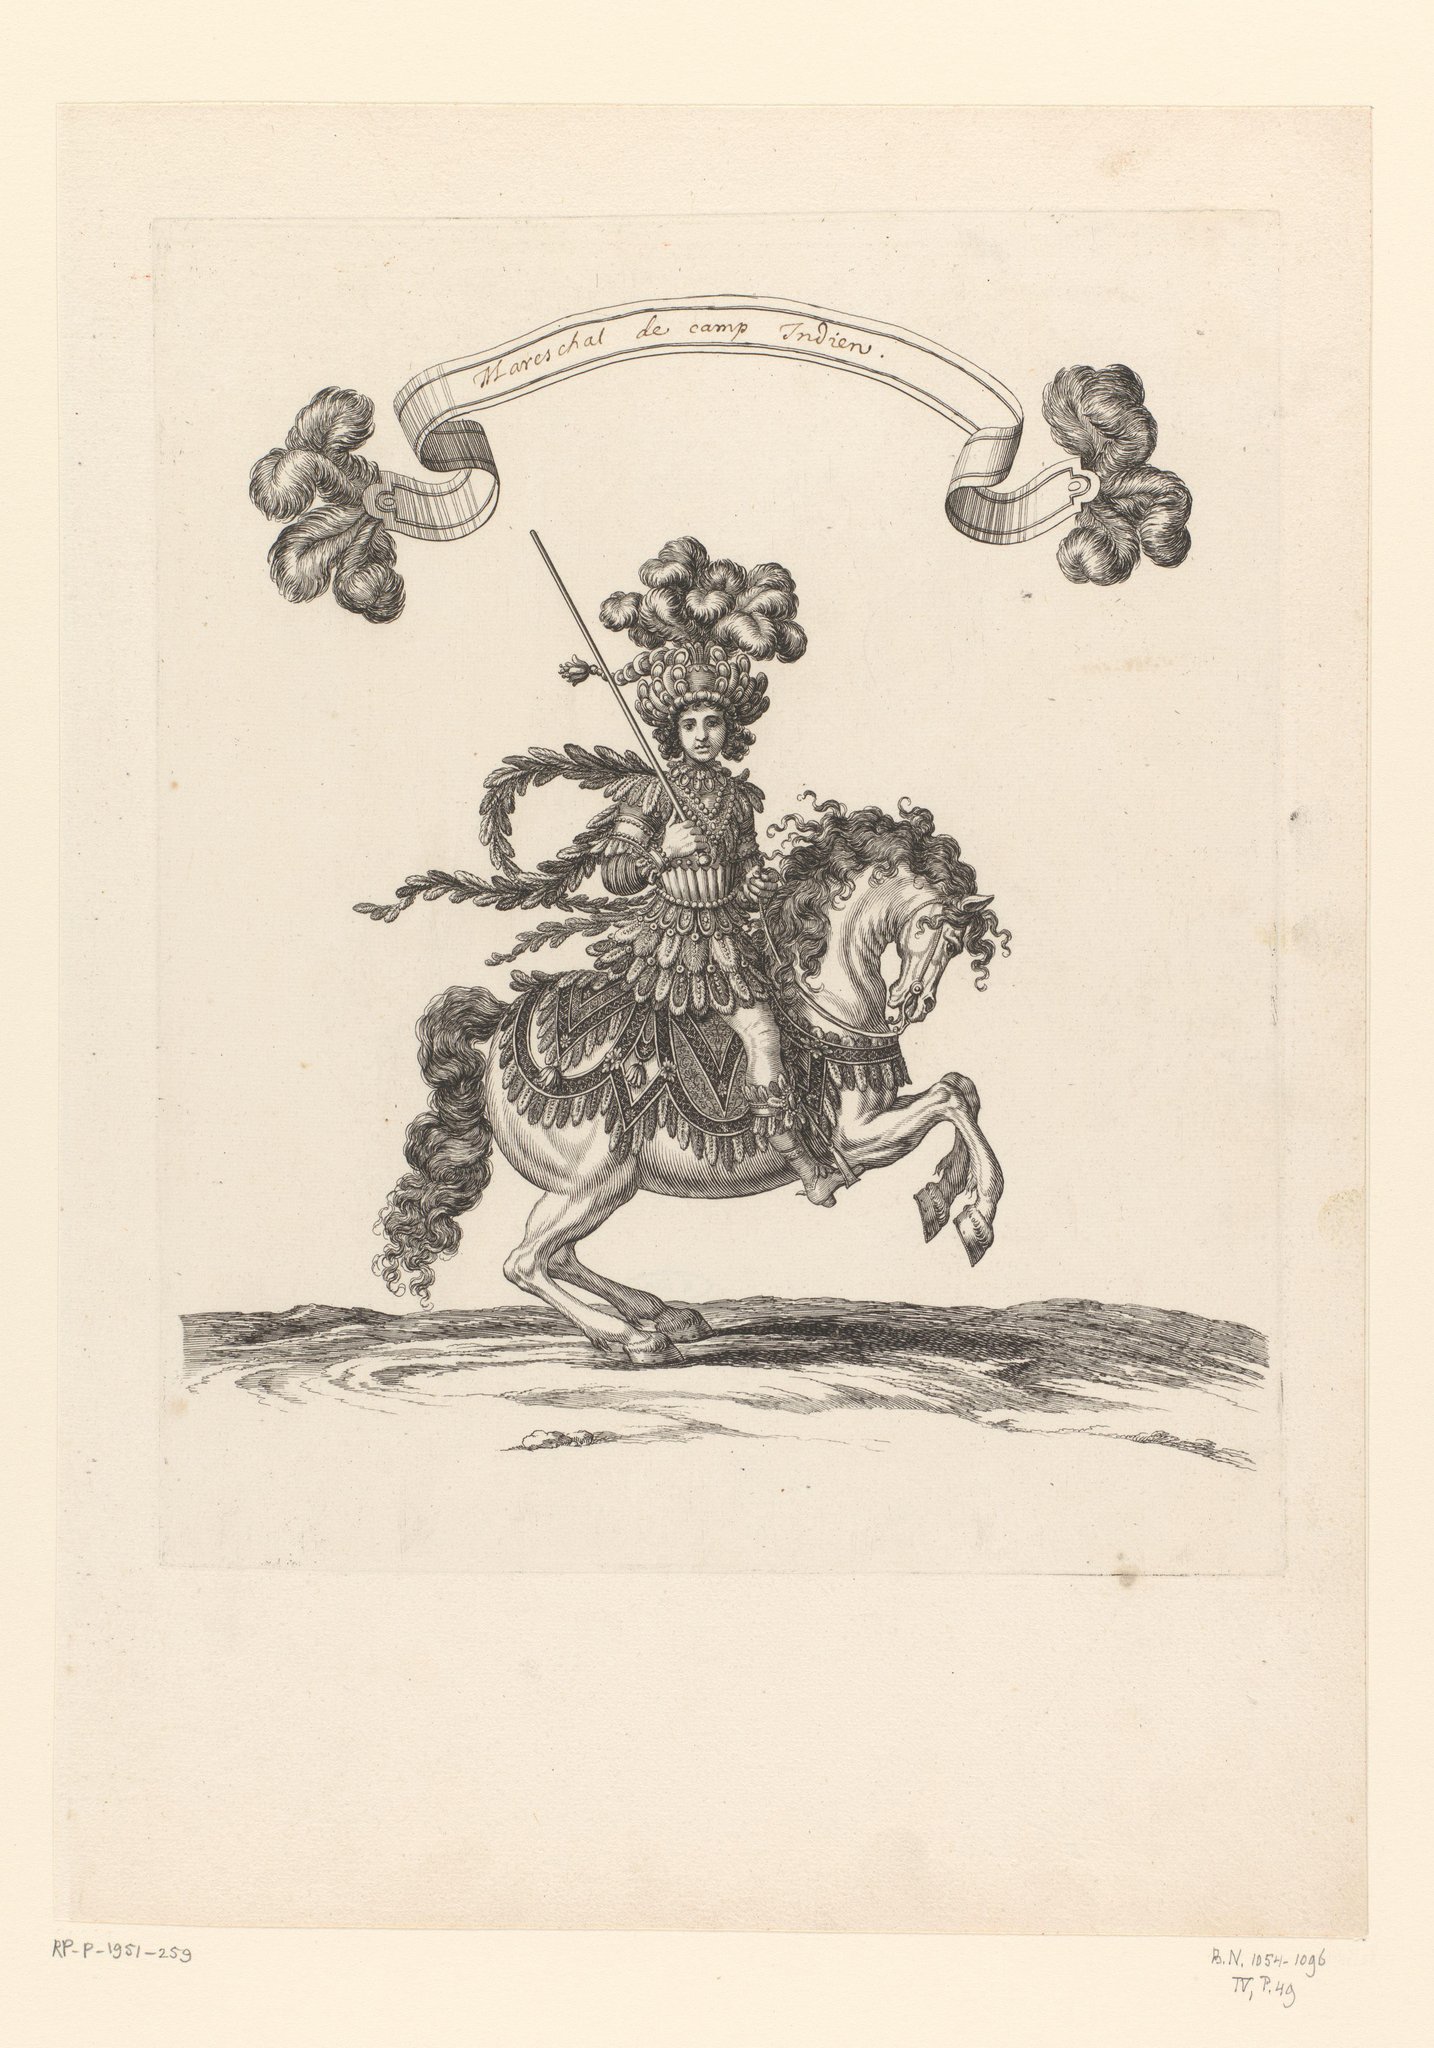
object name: print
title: Mareschal de camp Indien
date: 1670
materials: paper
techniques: etching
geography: france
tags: dress-up party, indigenous peoples of north america (+ costume), tournament, horse, festivities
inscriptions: collector's mark: Lugt 2228, inscription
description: Prent uit: Perrault, Charles. Courses de testes et de bague faites par le Roy et par les princes et seigneurs de sa cour en l'année M.DC.LXII. Parijs: Imprimerie Royale, 1670. De prenten illustreren de door Lodewijk XIV georganiseerde festiviteiten in juni 1662 te Tuileries, zoals steekspelen met figuren in verschillende kostuums.